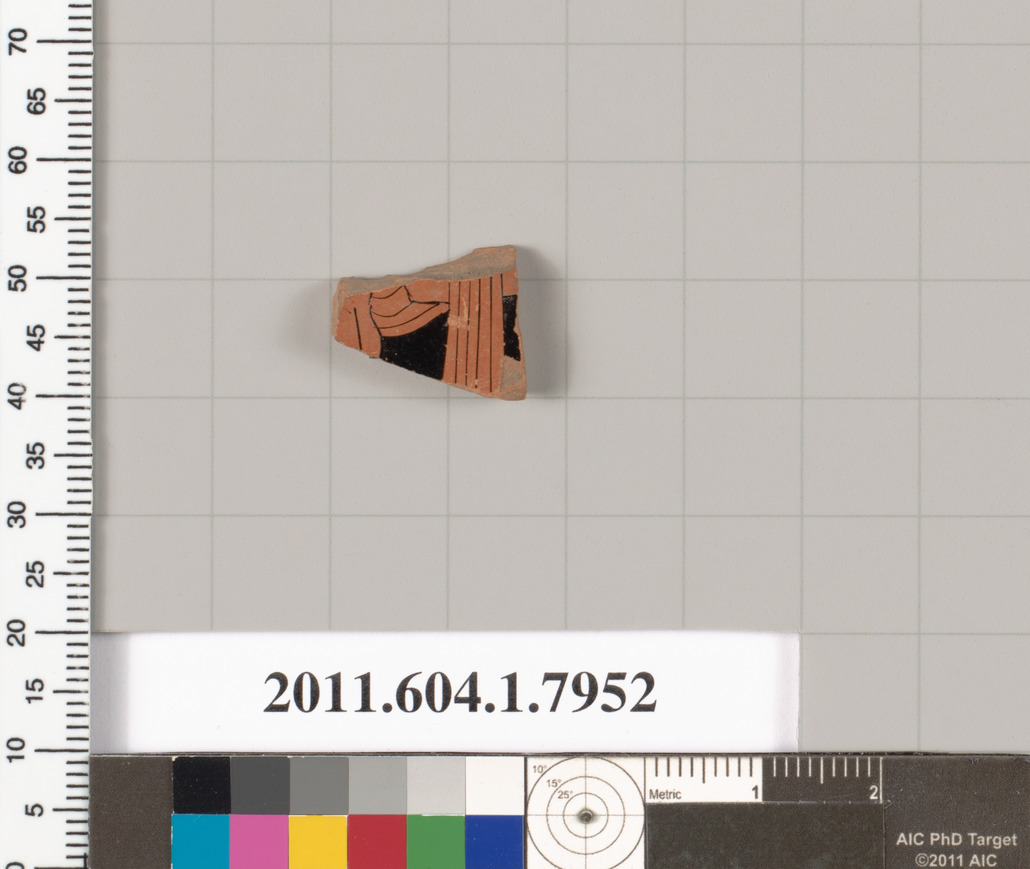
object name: kylix fragment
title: Terracotta fragment of a kylix (drinking cup)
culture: greek, attic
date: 460-450 BCE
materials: terracotta